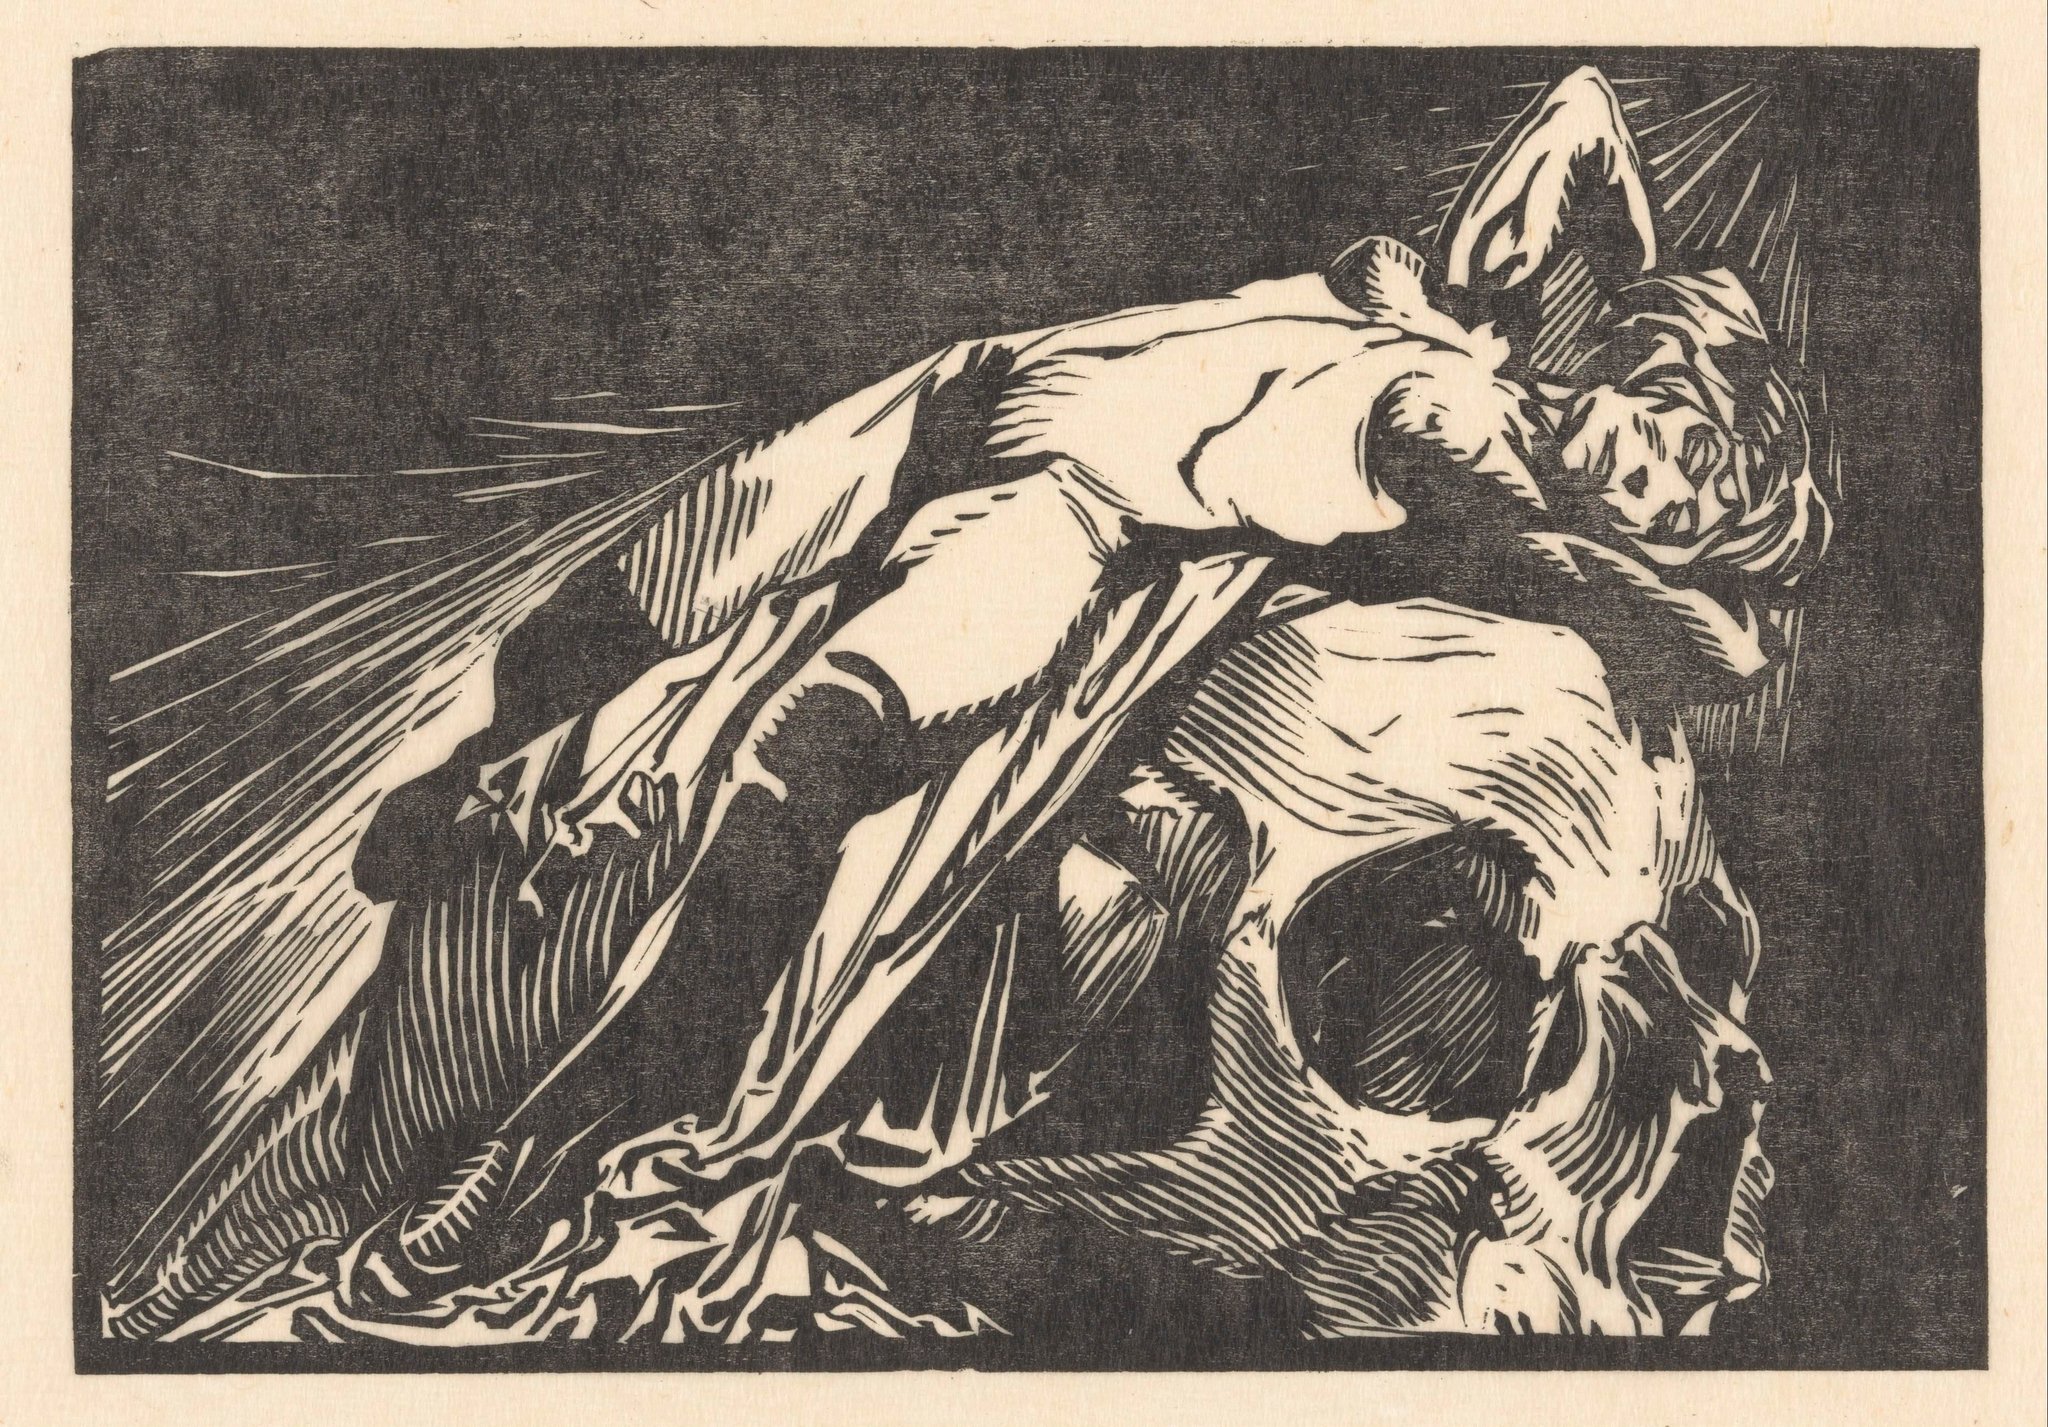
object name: print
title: Liggende vrouw op doodskop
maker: johannes josephus aarts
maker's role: draughtsman, print maker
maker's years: 1871-1934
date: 1881-1934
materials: paper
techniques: woodcut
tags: lying on the back with hands under the head - aa - female human figure, death's head, skull (symbol of death)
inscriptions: collector's mark: Lugt 2228, collector's mark: Lugt 2760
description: Een vrouw in een gewaad liggend op een doodskop. Ze ondersteunt haar achterhoofd met haar handen.